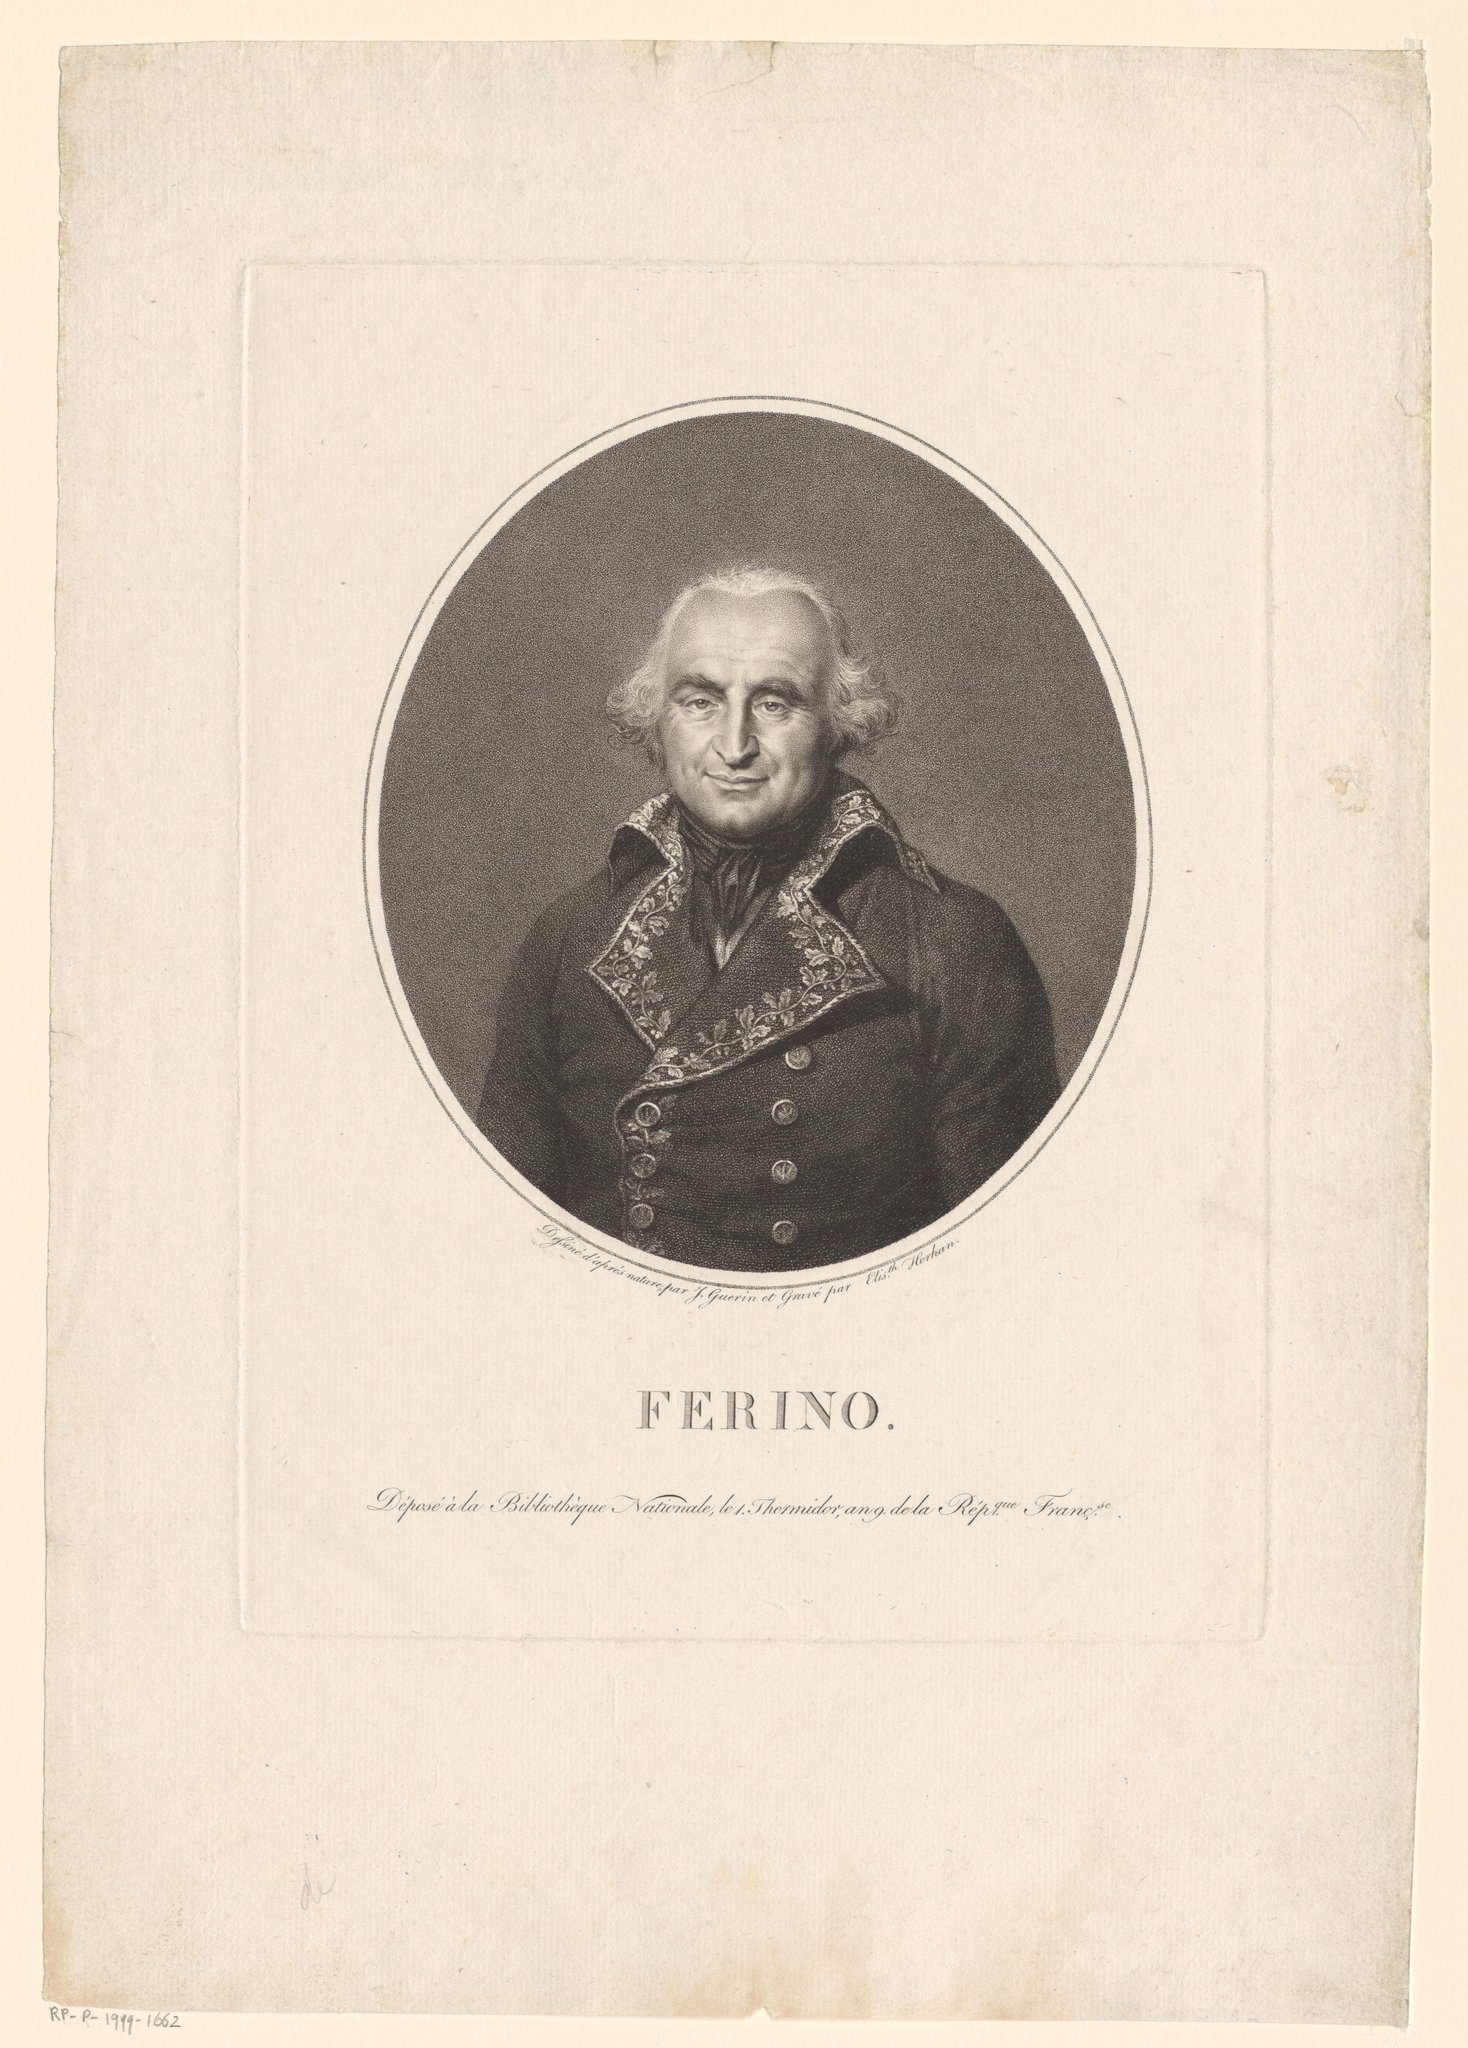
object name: print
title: Portret van Pierre Marie Barthélemy Ferino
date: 1798-1801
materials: paper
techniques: engraving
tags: paris, commander-in-chief, general, marshal, historical persons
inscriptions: collector's mark: Lugt 2228, : ‘Déposé à la Bibliothèque Nationale, le 1. Thermidor, an 9. de la Rep.que Franc.se’, collector's mark: Lugt 2760